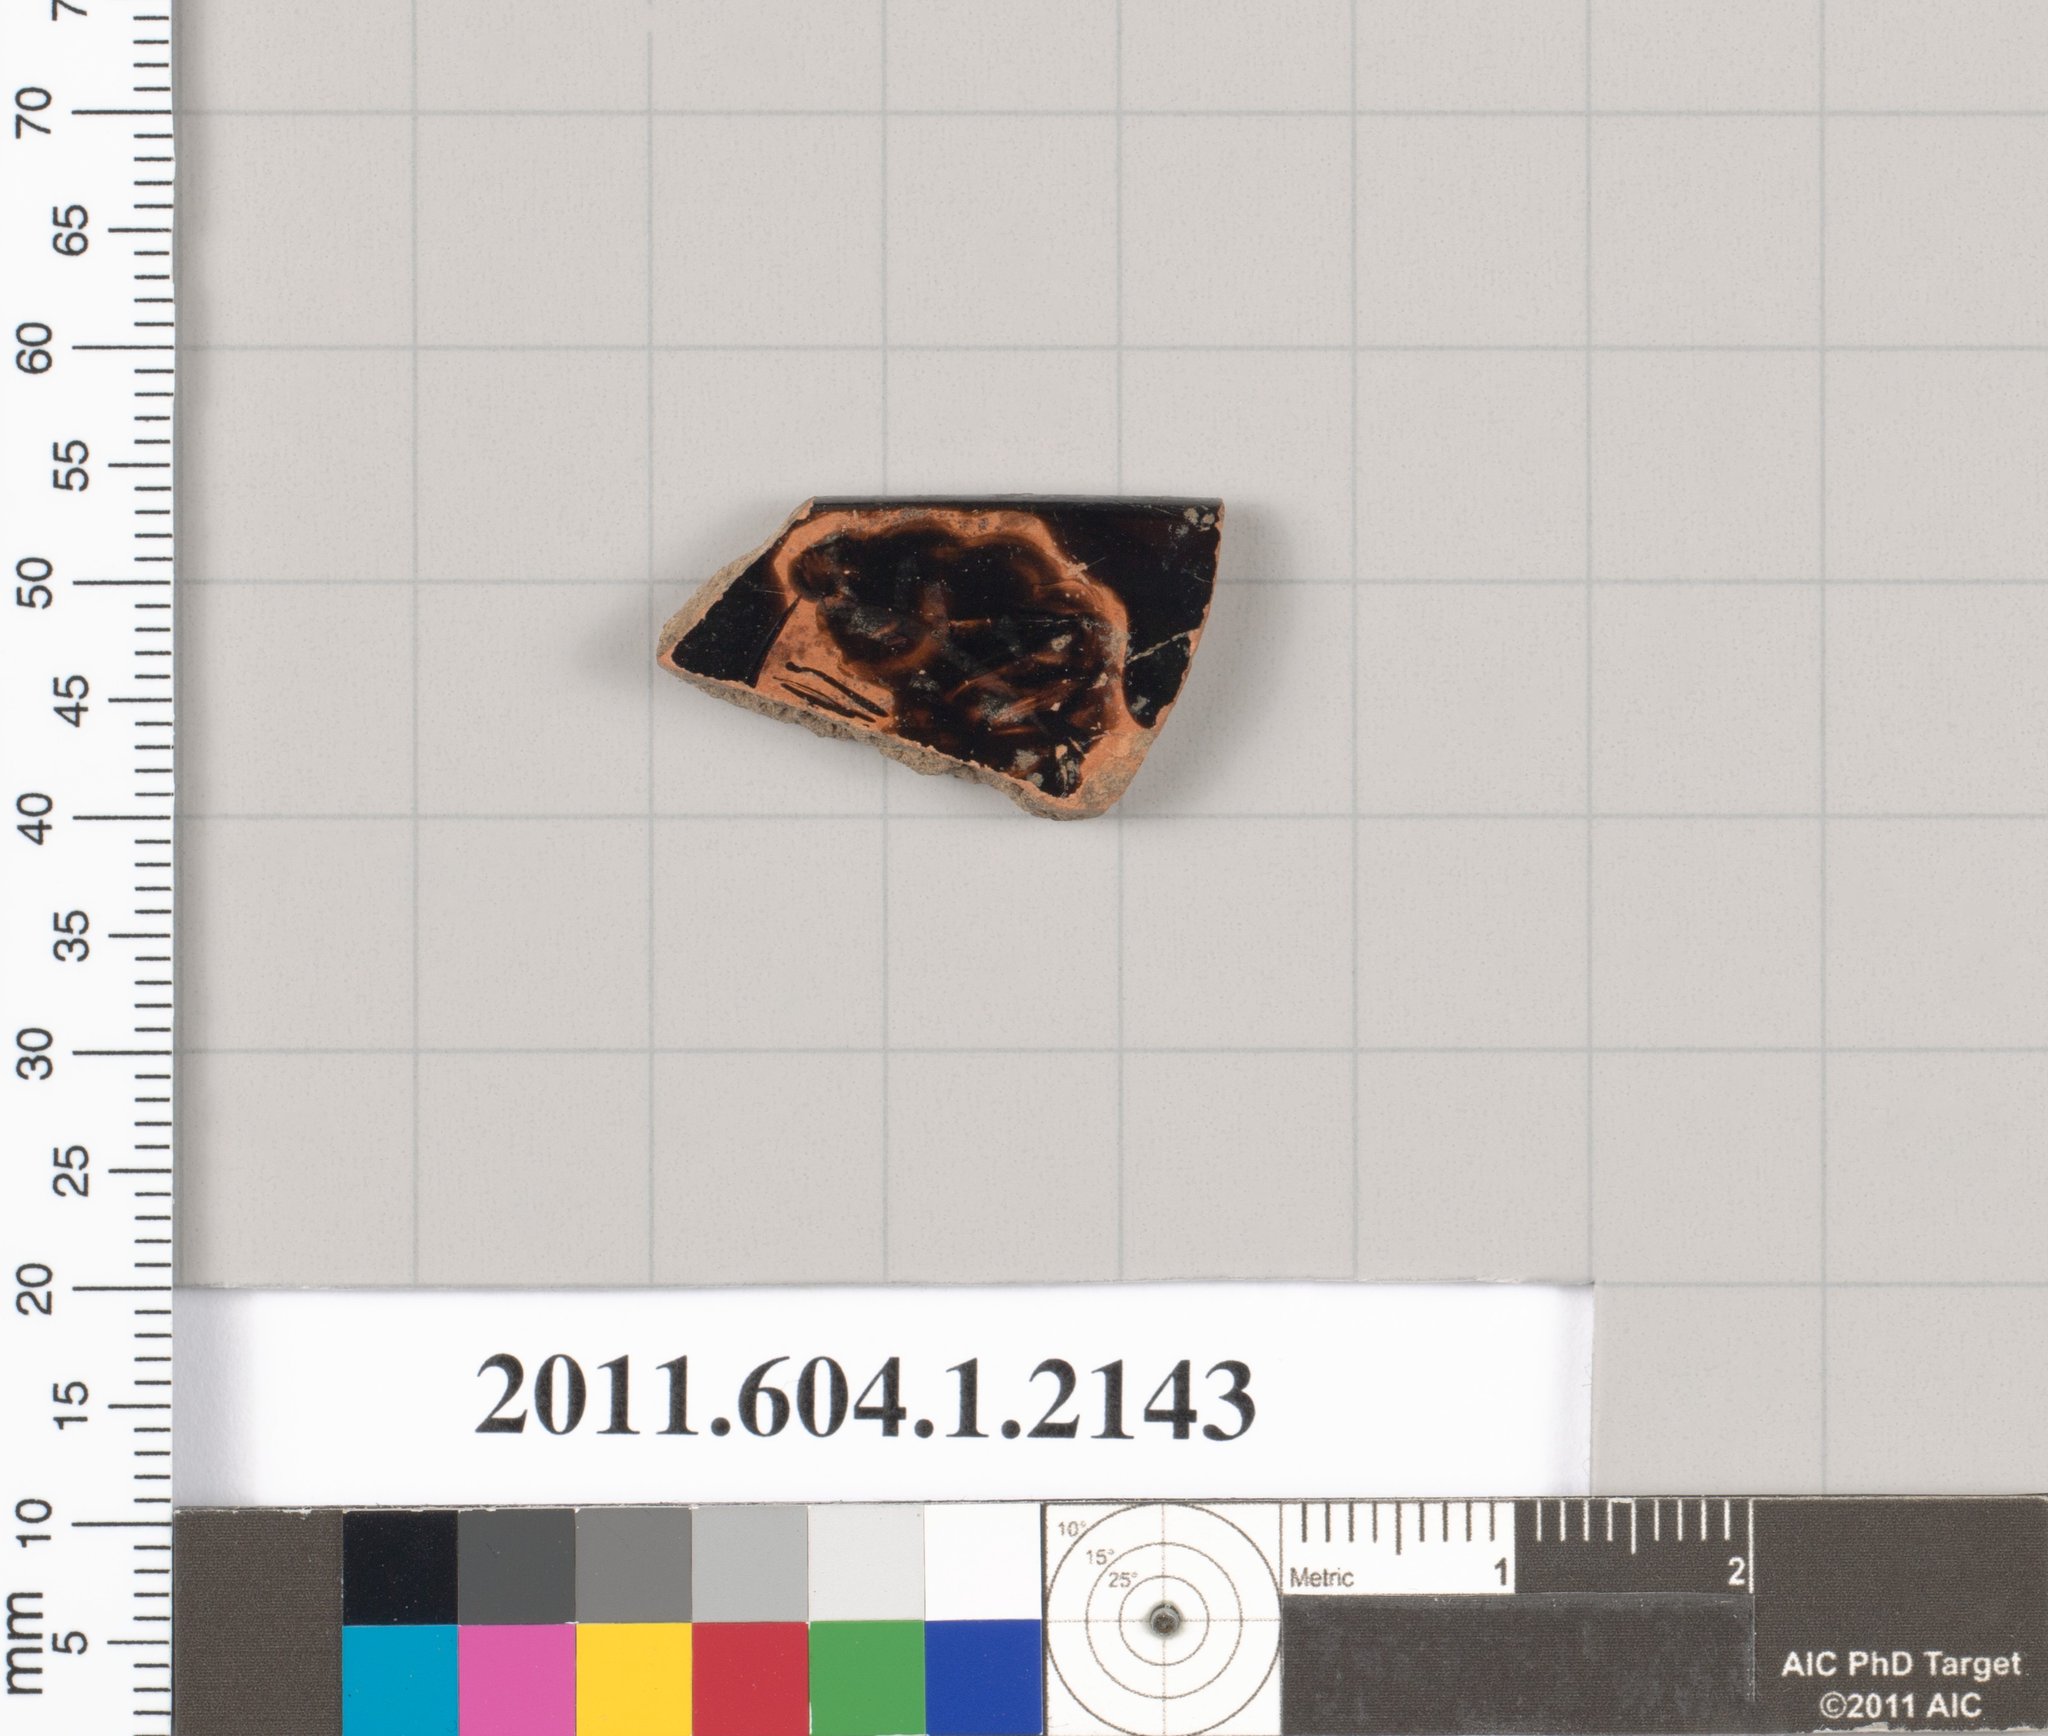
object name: kylix fragment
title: Terracotta rim fragment of a kylix (drinking cup)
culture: greek, attic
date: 467-435 BCE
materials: terracotta